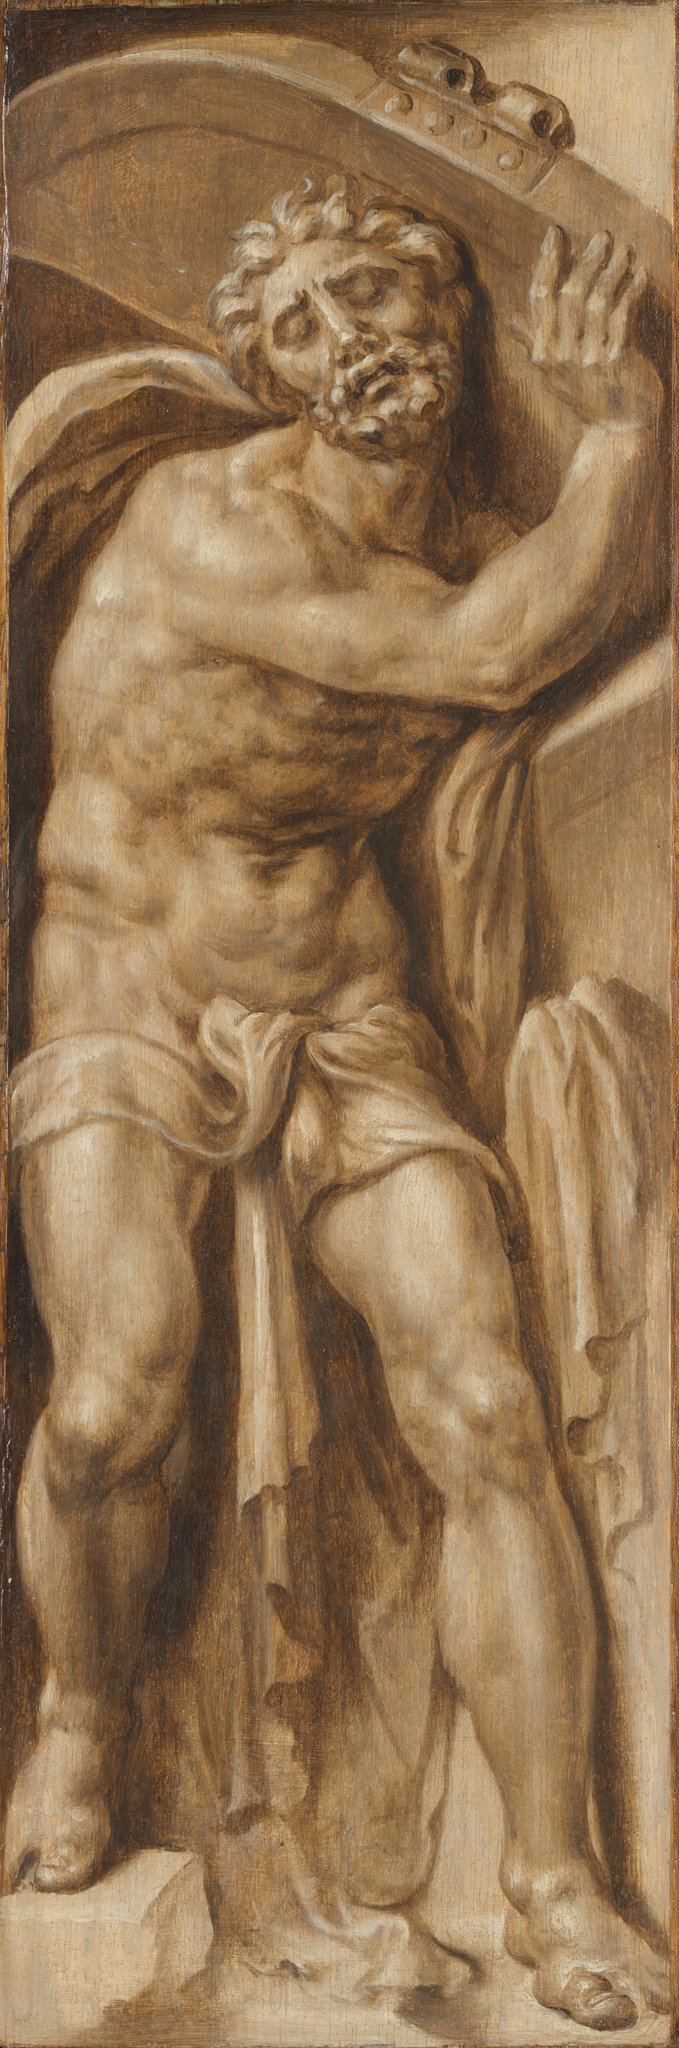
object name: painting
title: Triumph over Death: Samson Carrying the Gate of Gaza | Hercules Slaying the Centaur Nessus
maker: martinus van heemskerck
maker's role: draughtsman, painter, print maker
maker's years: 1498-1574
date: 1555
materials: oil, paint, panel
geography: haarlem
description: Samson escaped his murderers by wrenching apart the city gate of Gaza hinges and all, and running up the hill. In Heemskerk’s time this scene was considered as the forerunner (prefiguration) of Christ’s resurrection from the dead. Hercules also triumphs over deathhere. He kills the centaur Nessus, whose poisonous blood would prove fatal to Hercules years later, resulting in his eternal life on Mount Olympus.